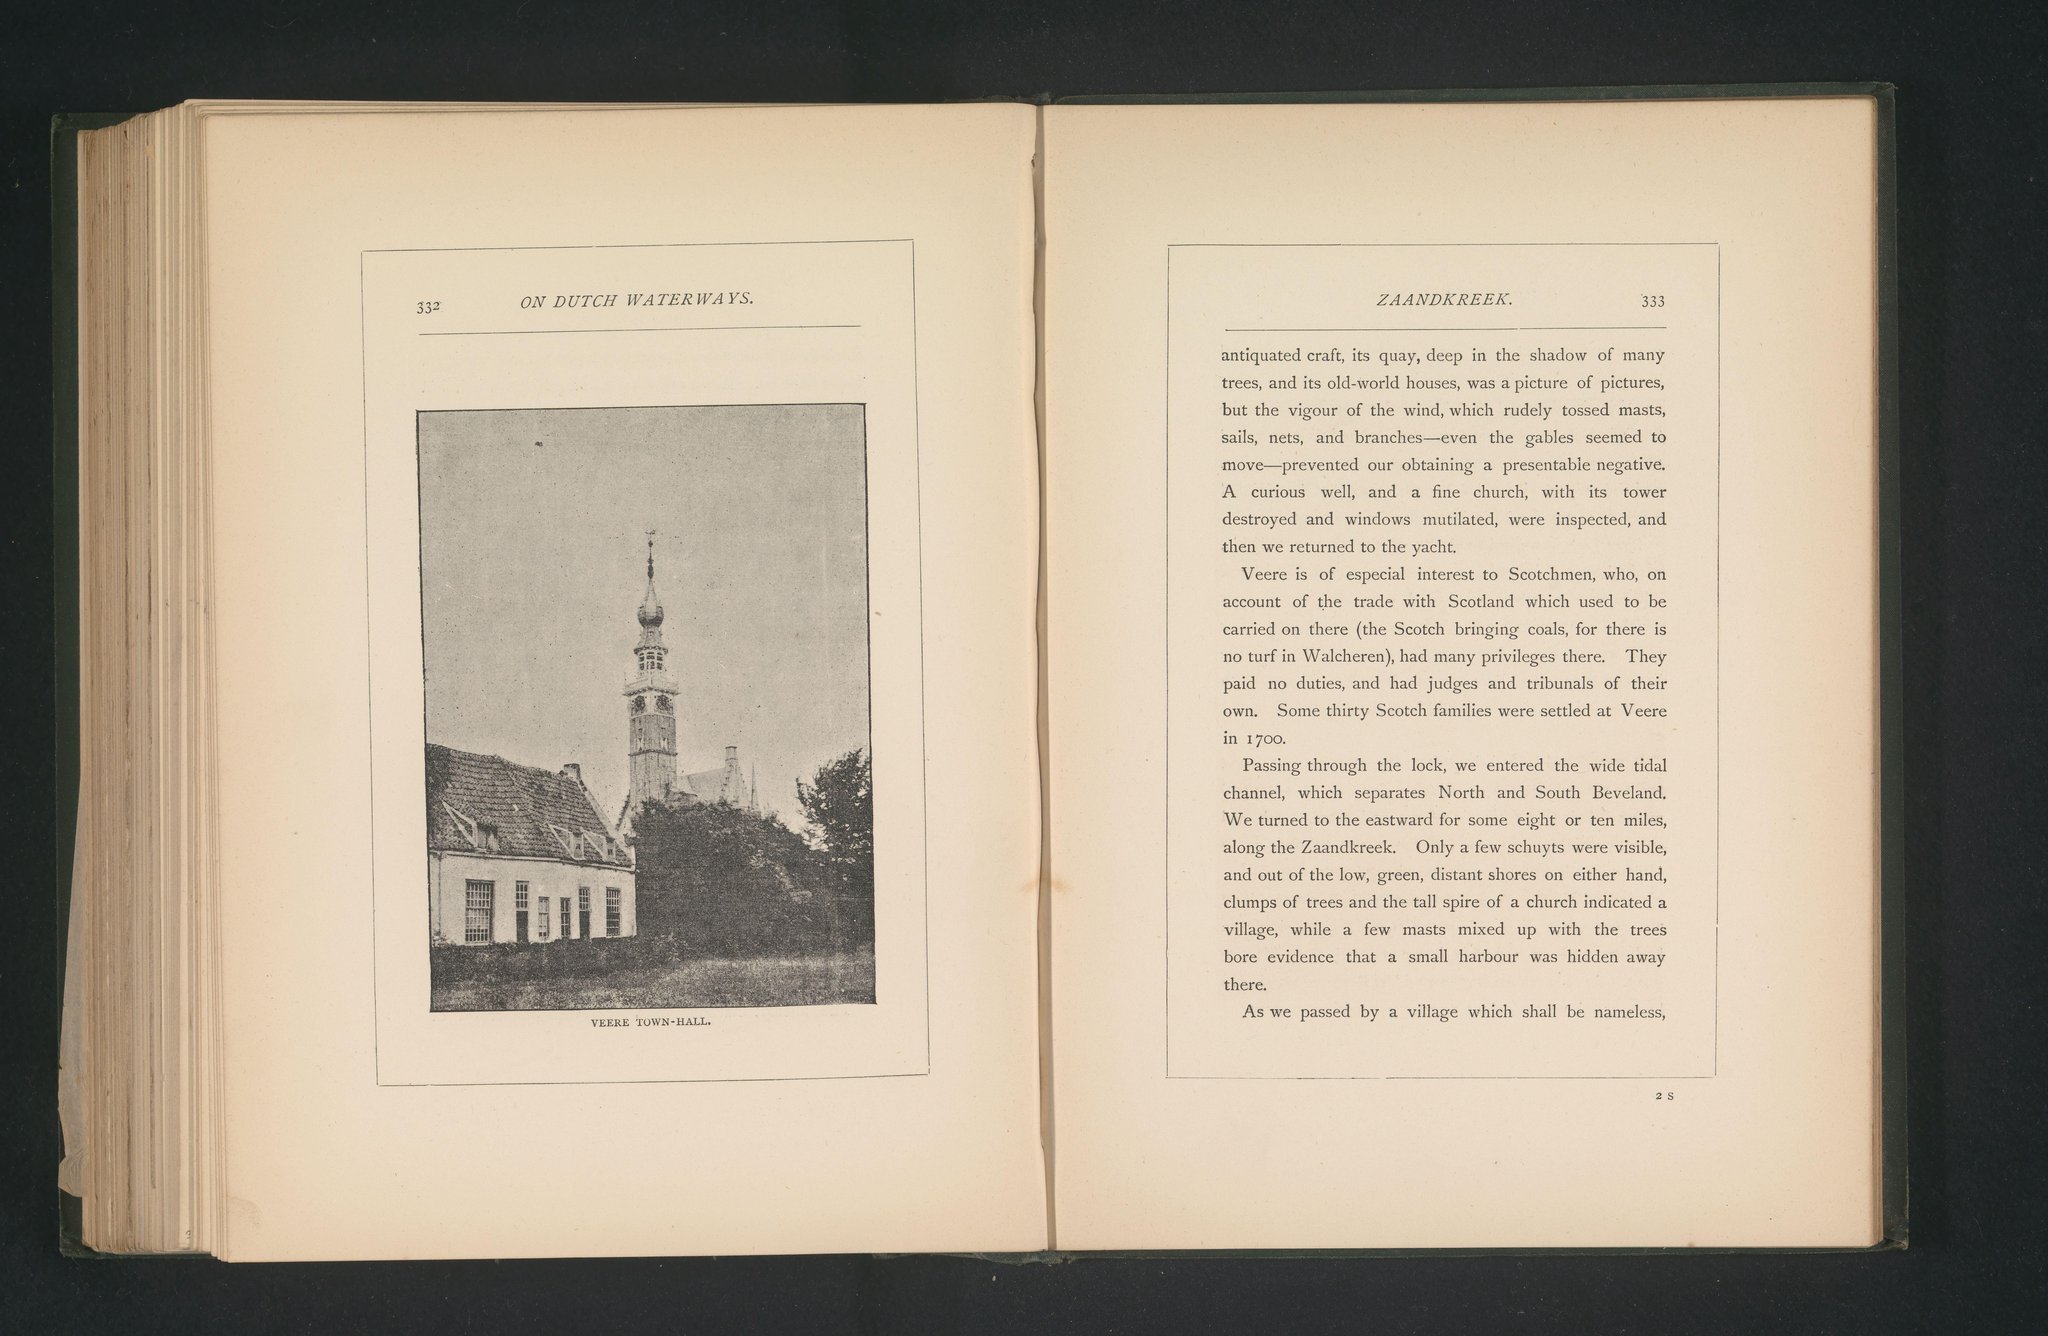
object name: photomechanical print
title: Gezicht op het stadhuis van Veere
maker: george christopher davies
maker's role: fotograaf, geoloog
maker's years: 1849-1922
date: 1881-1886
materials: paper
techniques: autotype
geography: london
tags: townhall, civic architecture; edifices; dwellings